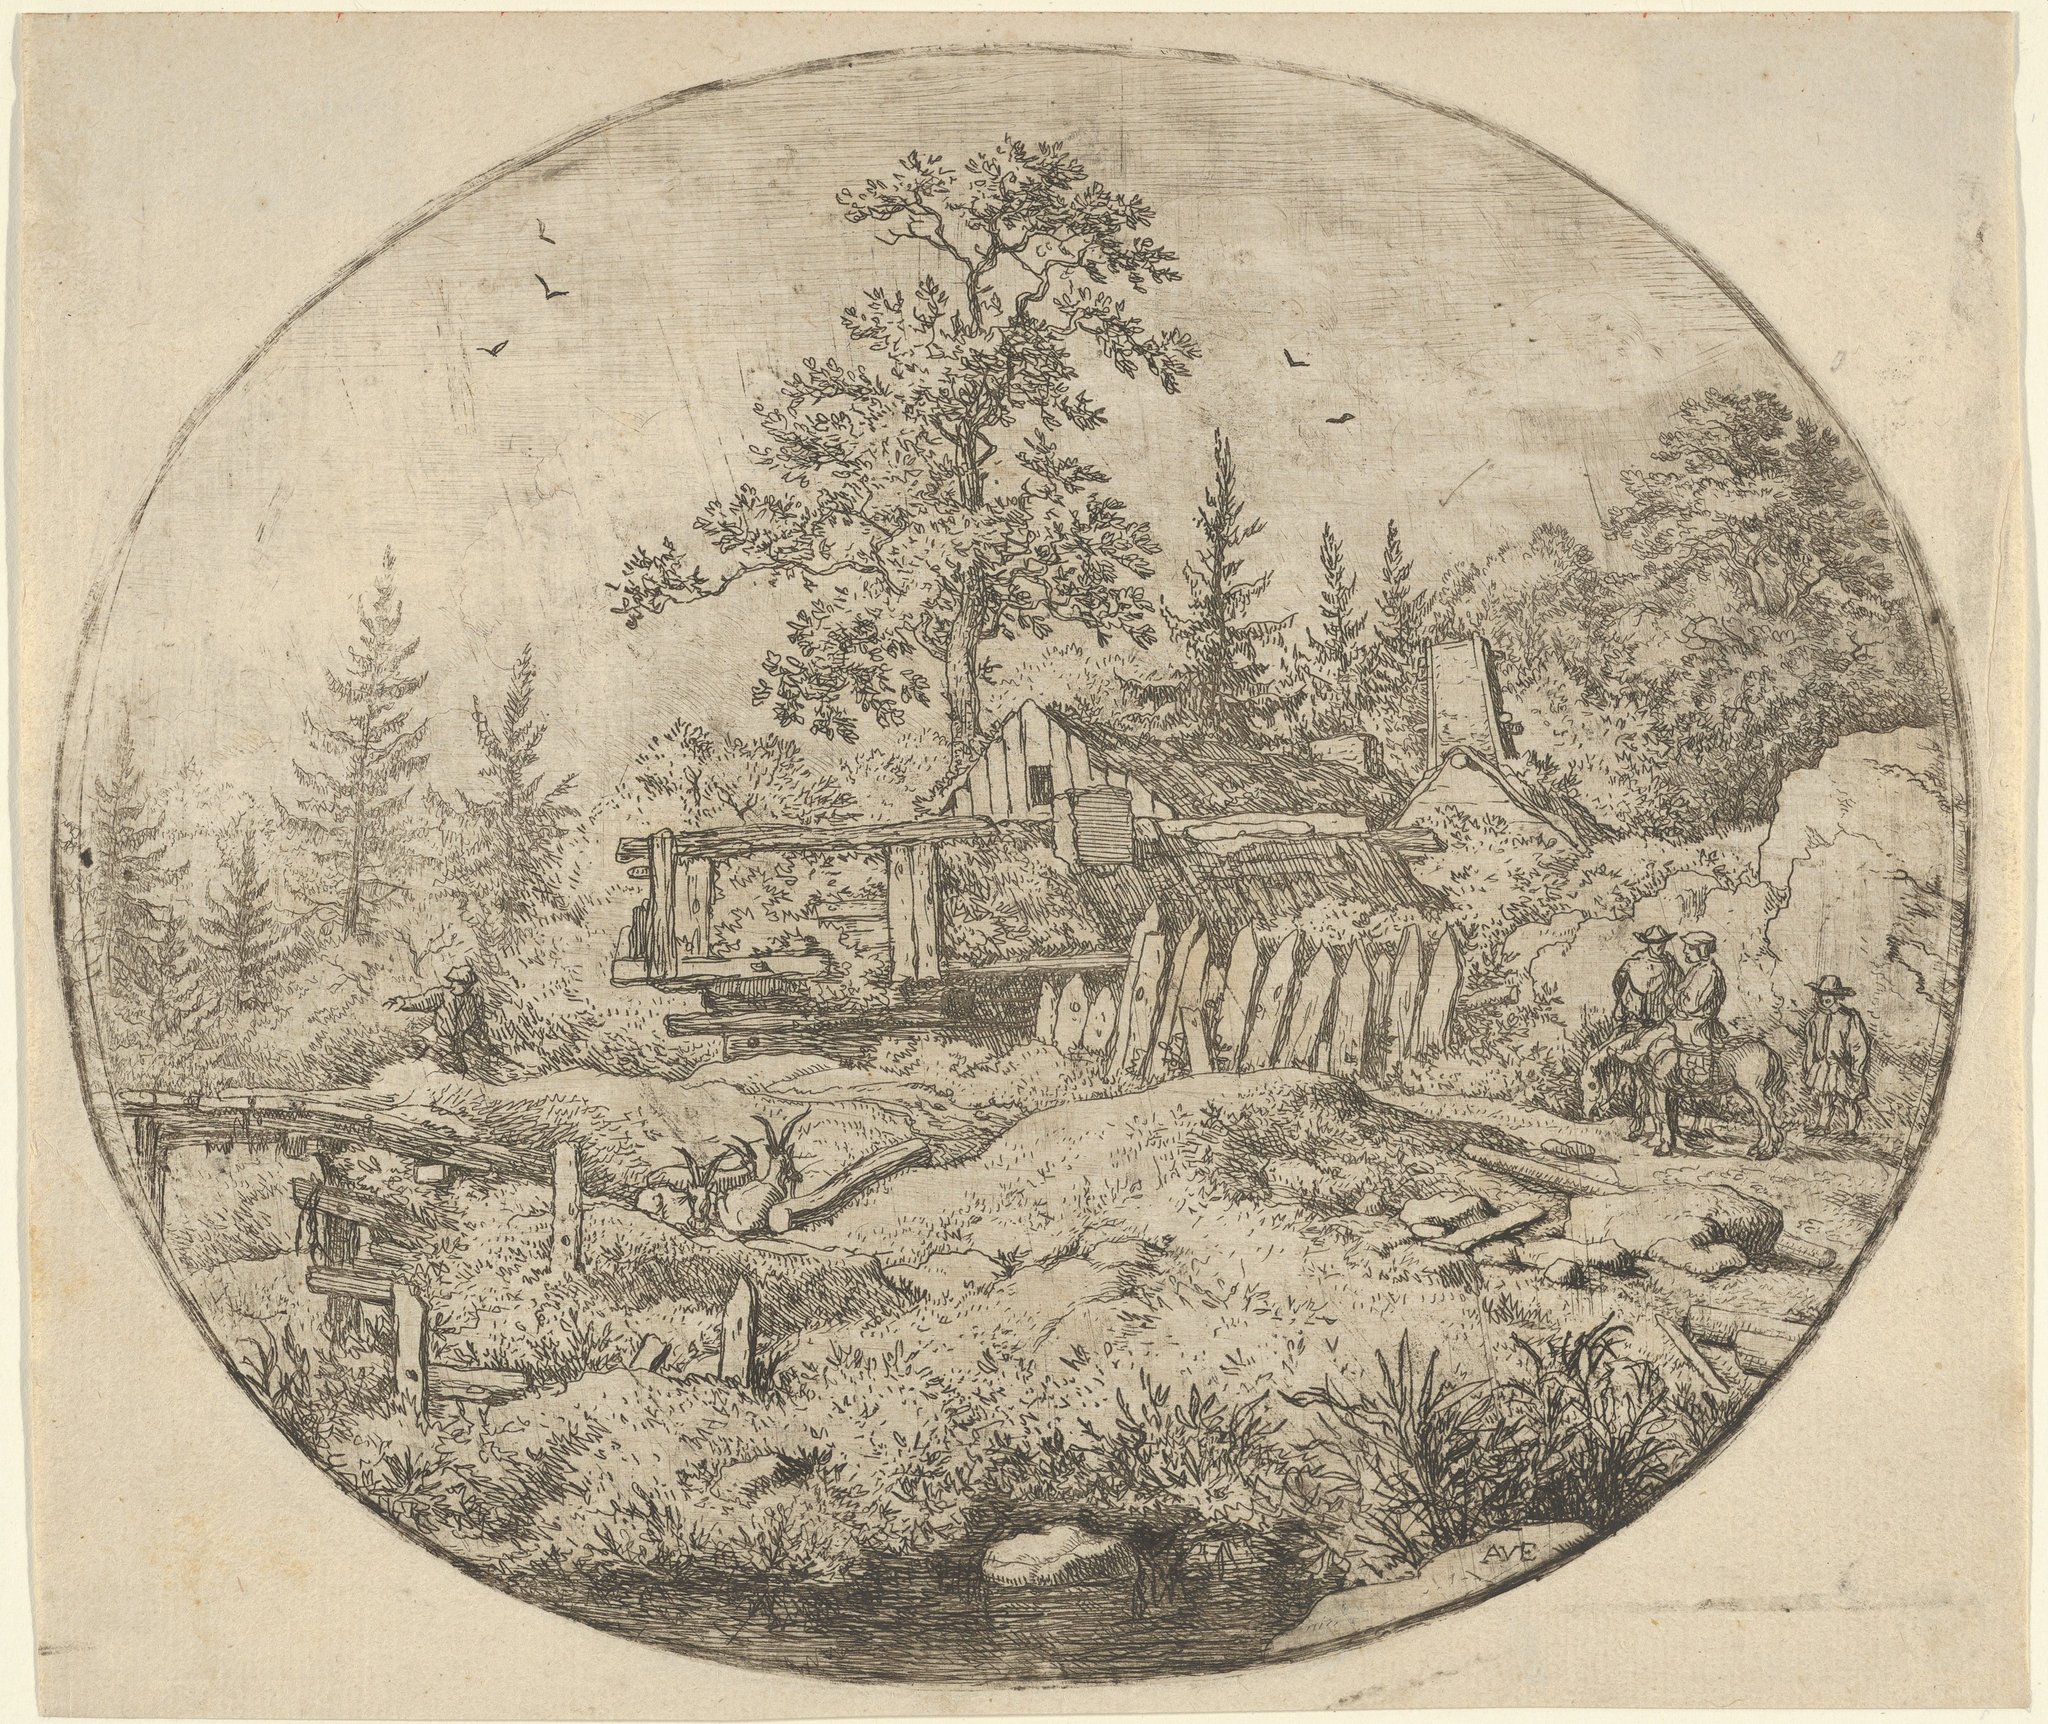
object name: print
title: The Landscape with the Wooden Bridge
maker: allart van everdingen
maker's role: artist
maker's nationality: dutch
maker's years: 1621-1675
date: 1621-1675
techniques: engraving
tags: bridges,landscapes